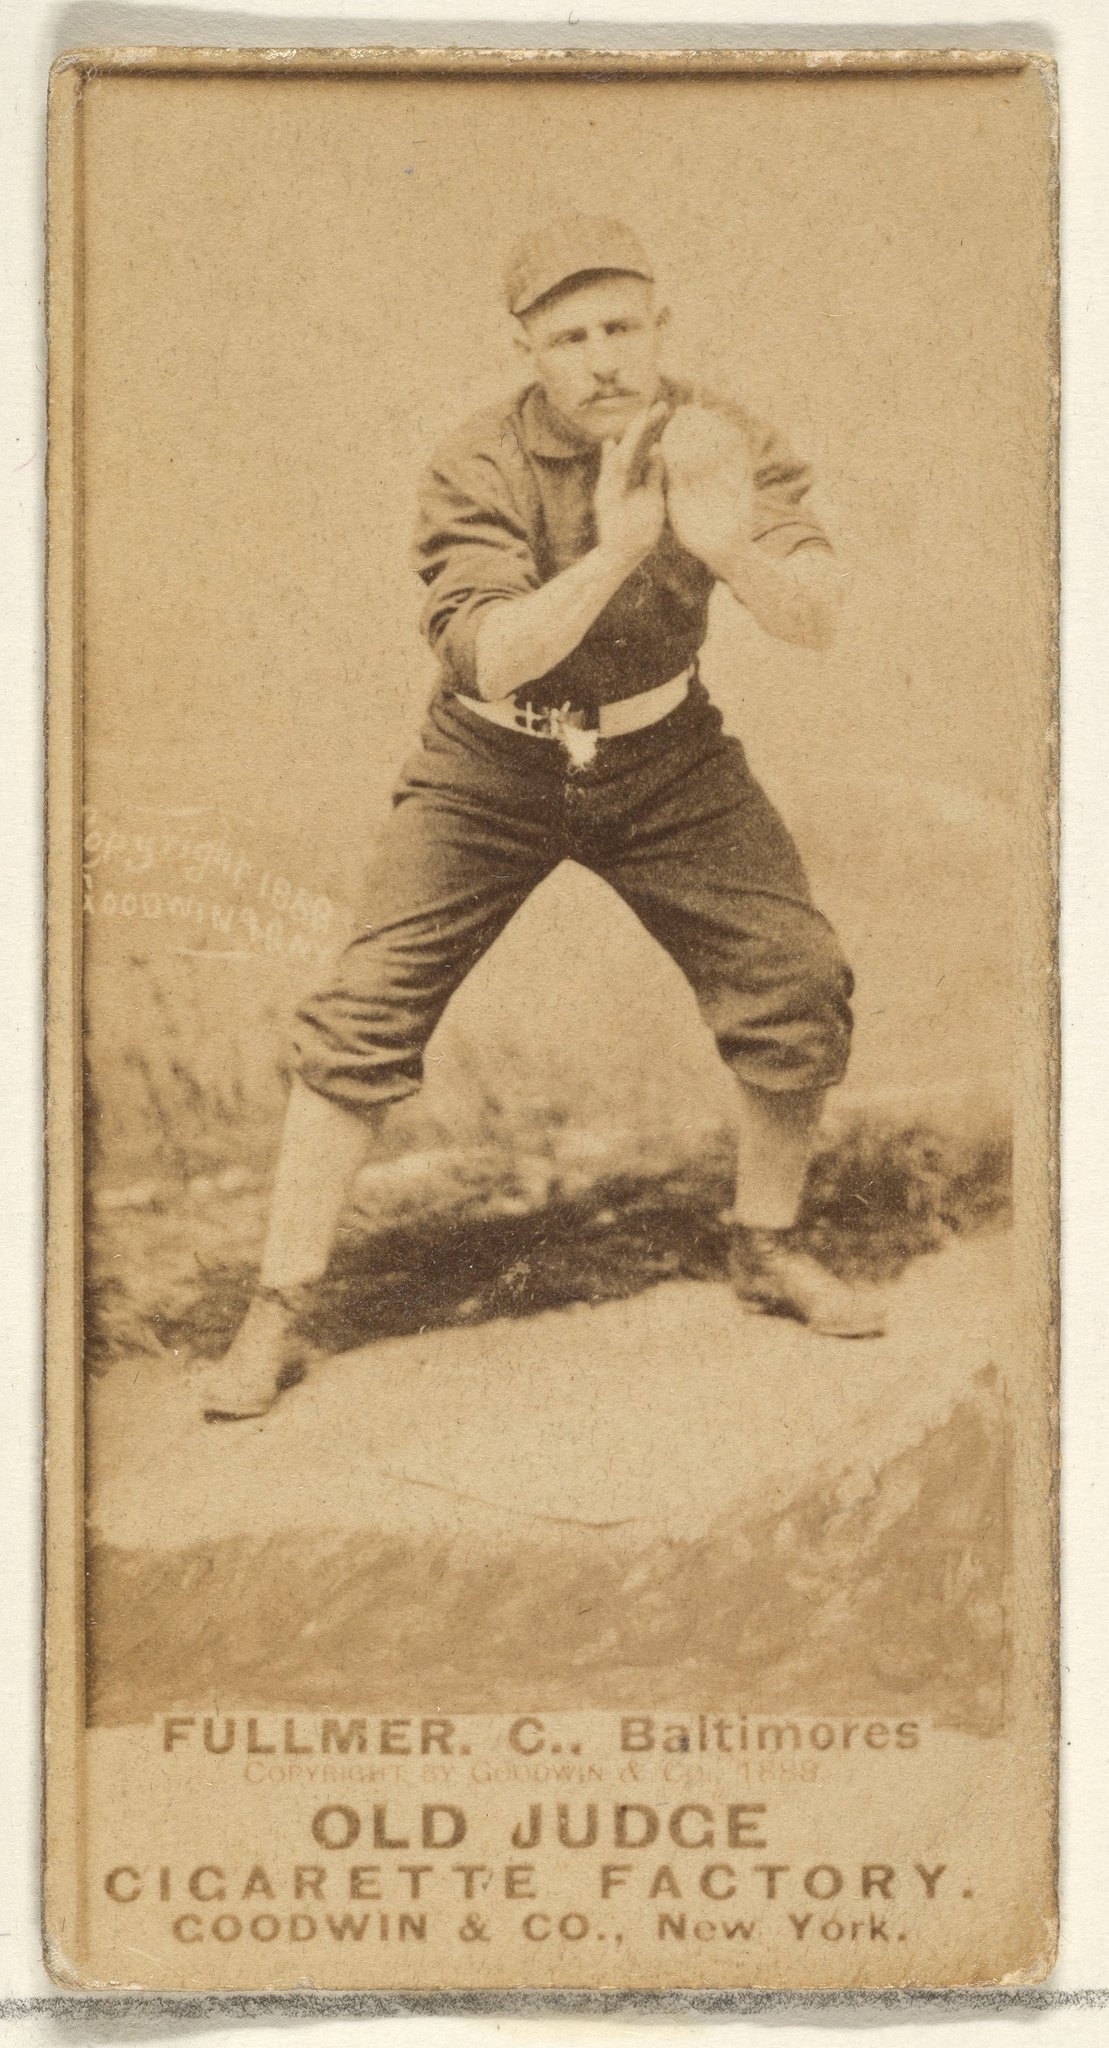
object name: baseball card, photograph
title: Fullmer, Catcher, Baltimore Orioles, from the Old Judge series (N172) for Old Judge Cigarettes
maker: goodwin & company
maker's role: publisher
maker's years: 1850-1950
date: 1888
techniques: albumen silver print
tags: men,portraits,baseball,athletes